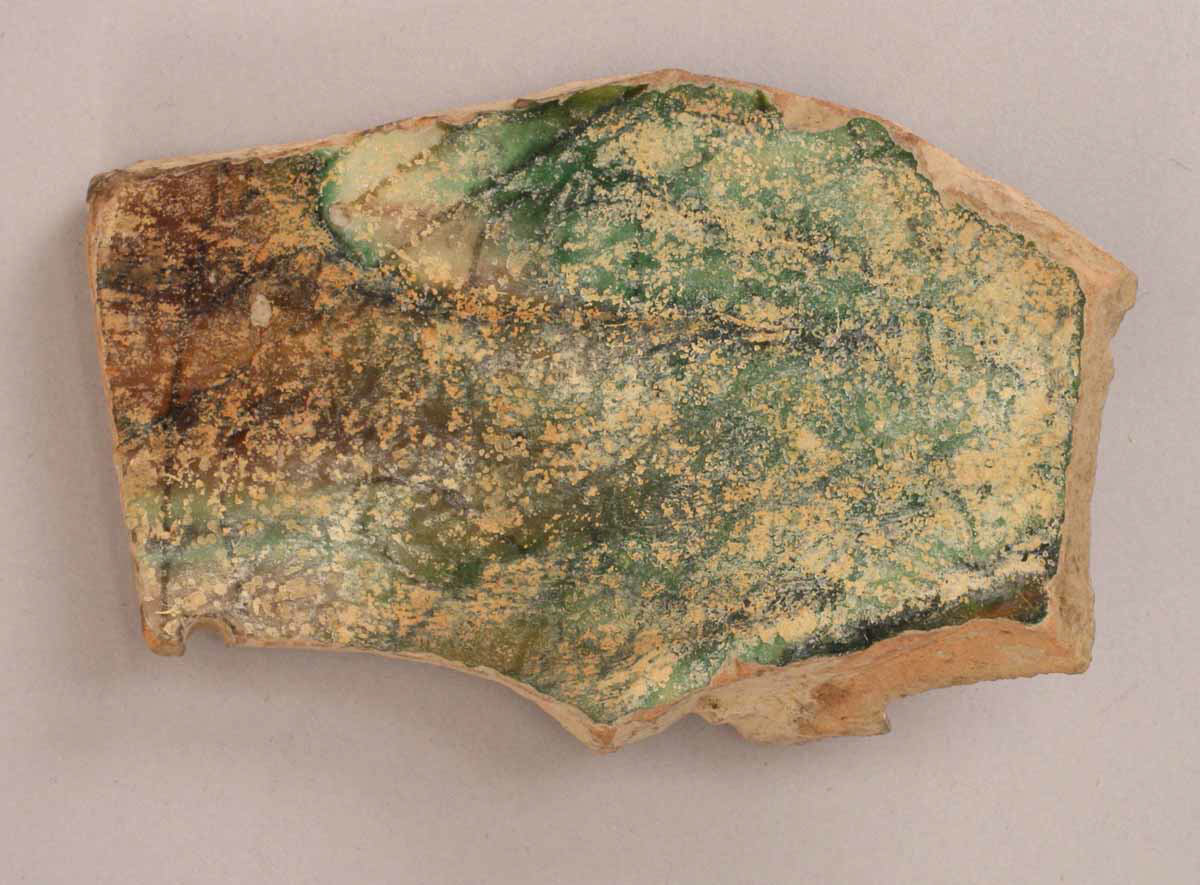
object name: fragment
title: Ceramic Fragment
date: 701-900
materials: earthenware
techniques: glazing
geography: iraq